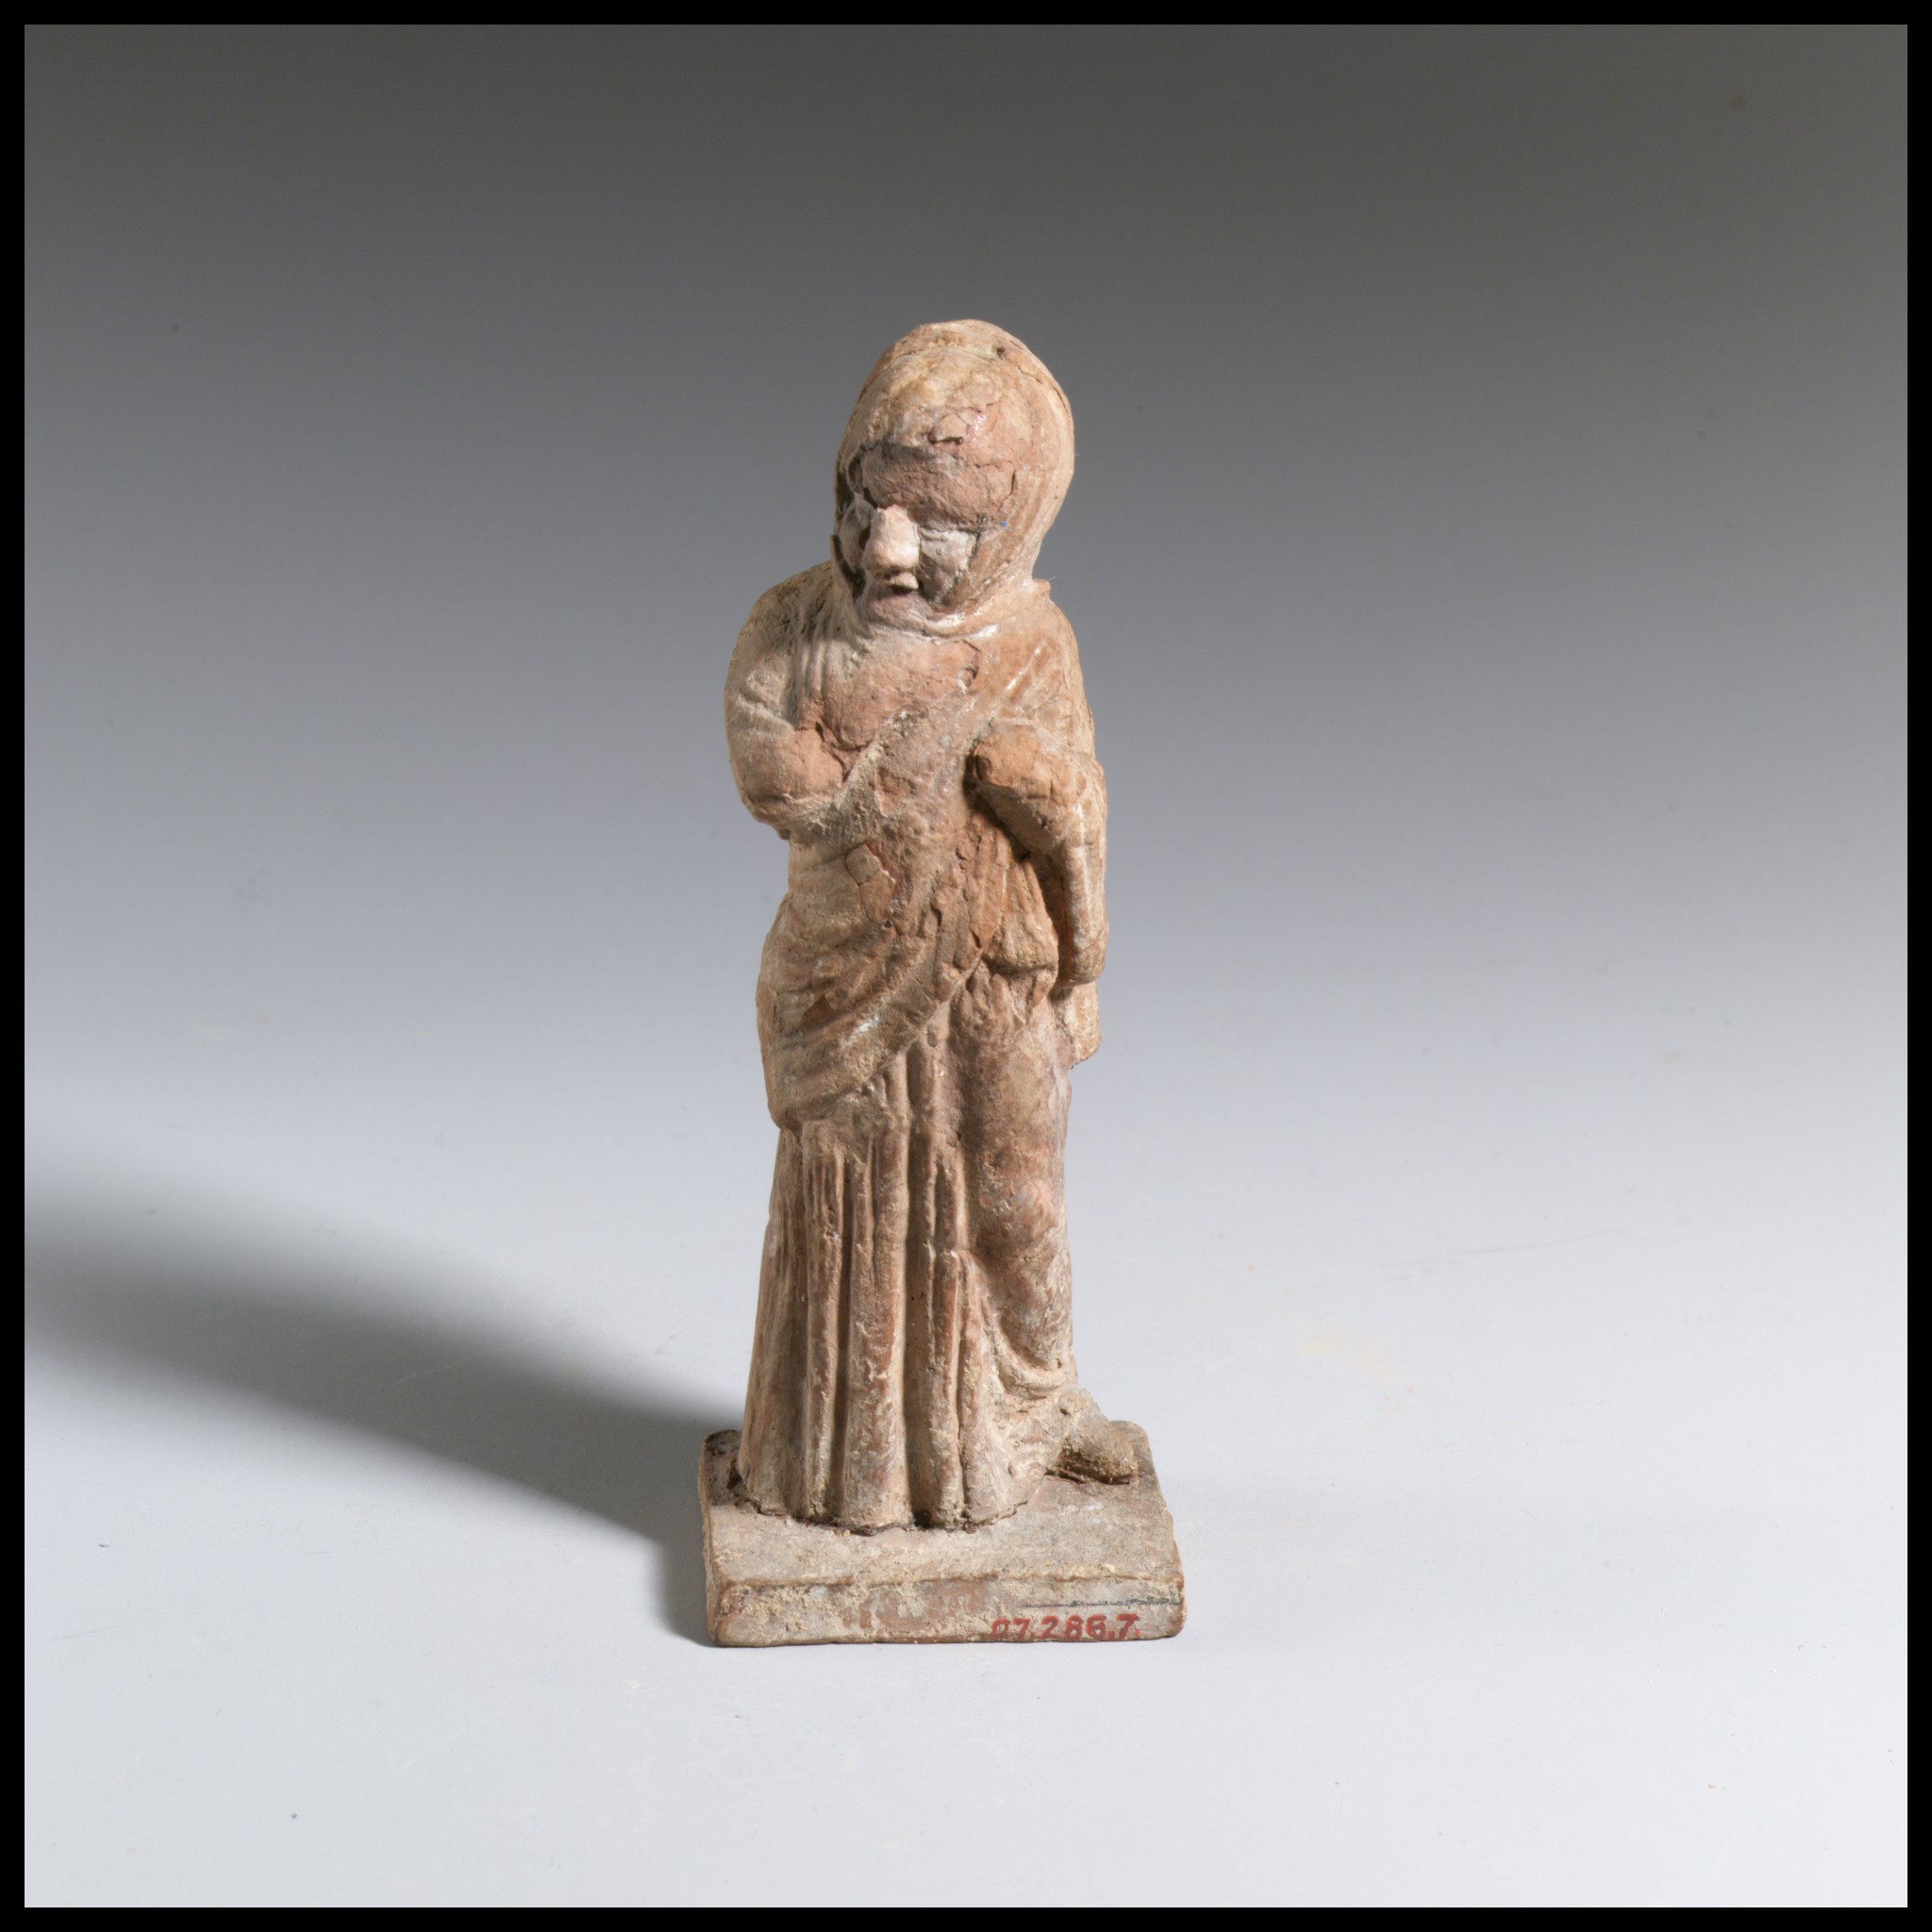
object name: statuette of a woman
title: Statuette of an old woman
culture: greek, attic or boeotian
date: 400-301 BCE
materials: terracotta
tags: women